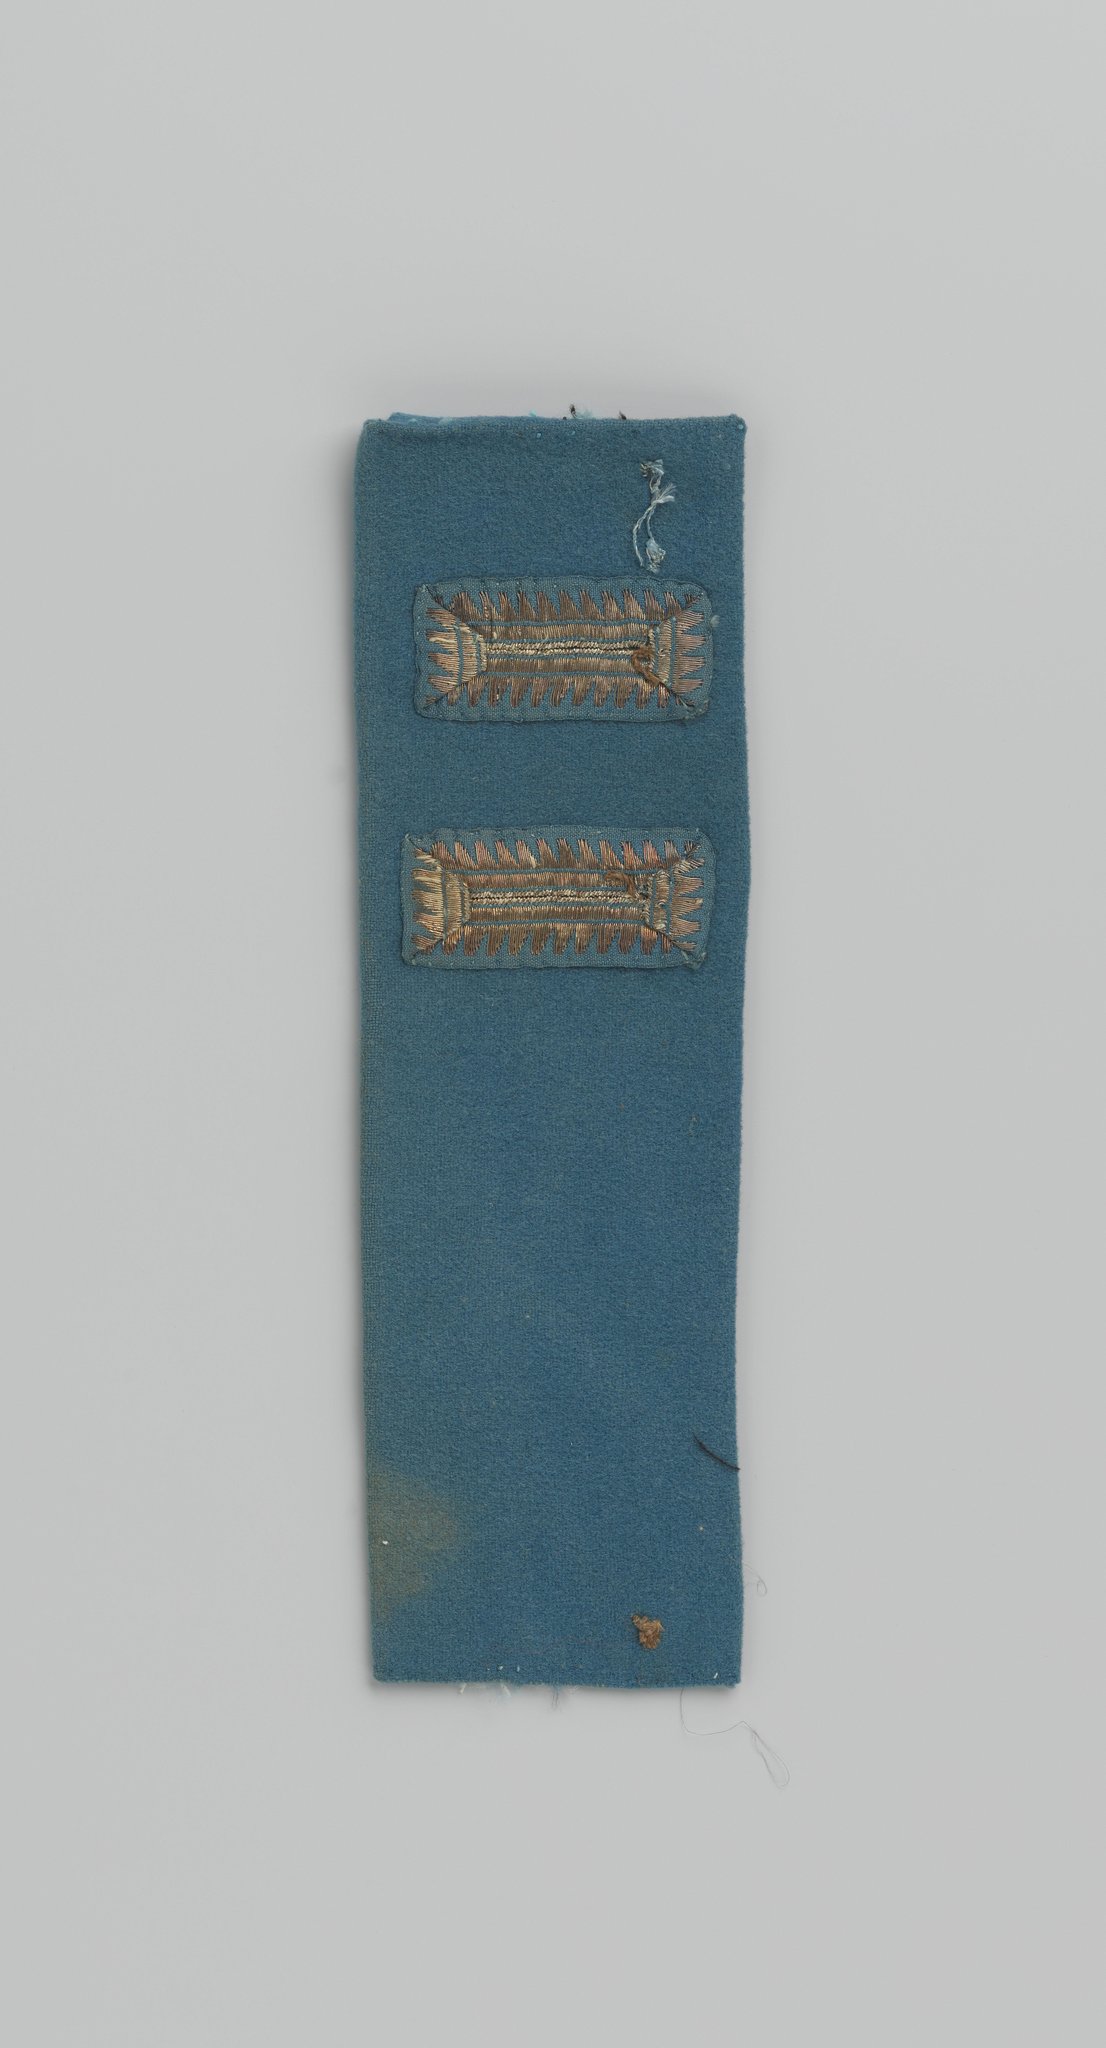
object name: cuff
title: Manchet van blauw laken met twee applicaties van zilverborduursel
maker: Anonymous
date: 1800-1825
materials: textile, thread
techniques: appliqué, embroidered, sewing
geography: netherlands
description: Uniformfragmenten bestaande uit: twee kragen, manchetomslagen, paar revers met één en zeven paar lissen, voering en rug- en voorpanden; voor livrei of schutterij (?). Deze uniformfragmenten waren op het moment van invoer nog niet beschikbaar en daar de aantallen e.d. onduidelijk zijn, is bij deze invoer alleen volstaan met de vermelding van de diverse onderdelen. De invoer per onderdeel moet dus nog volgen.